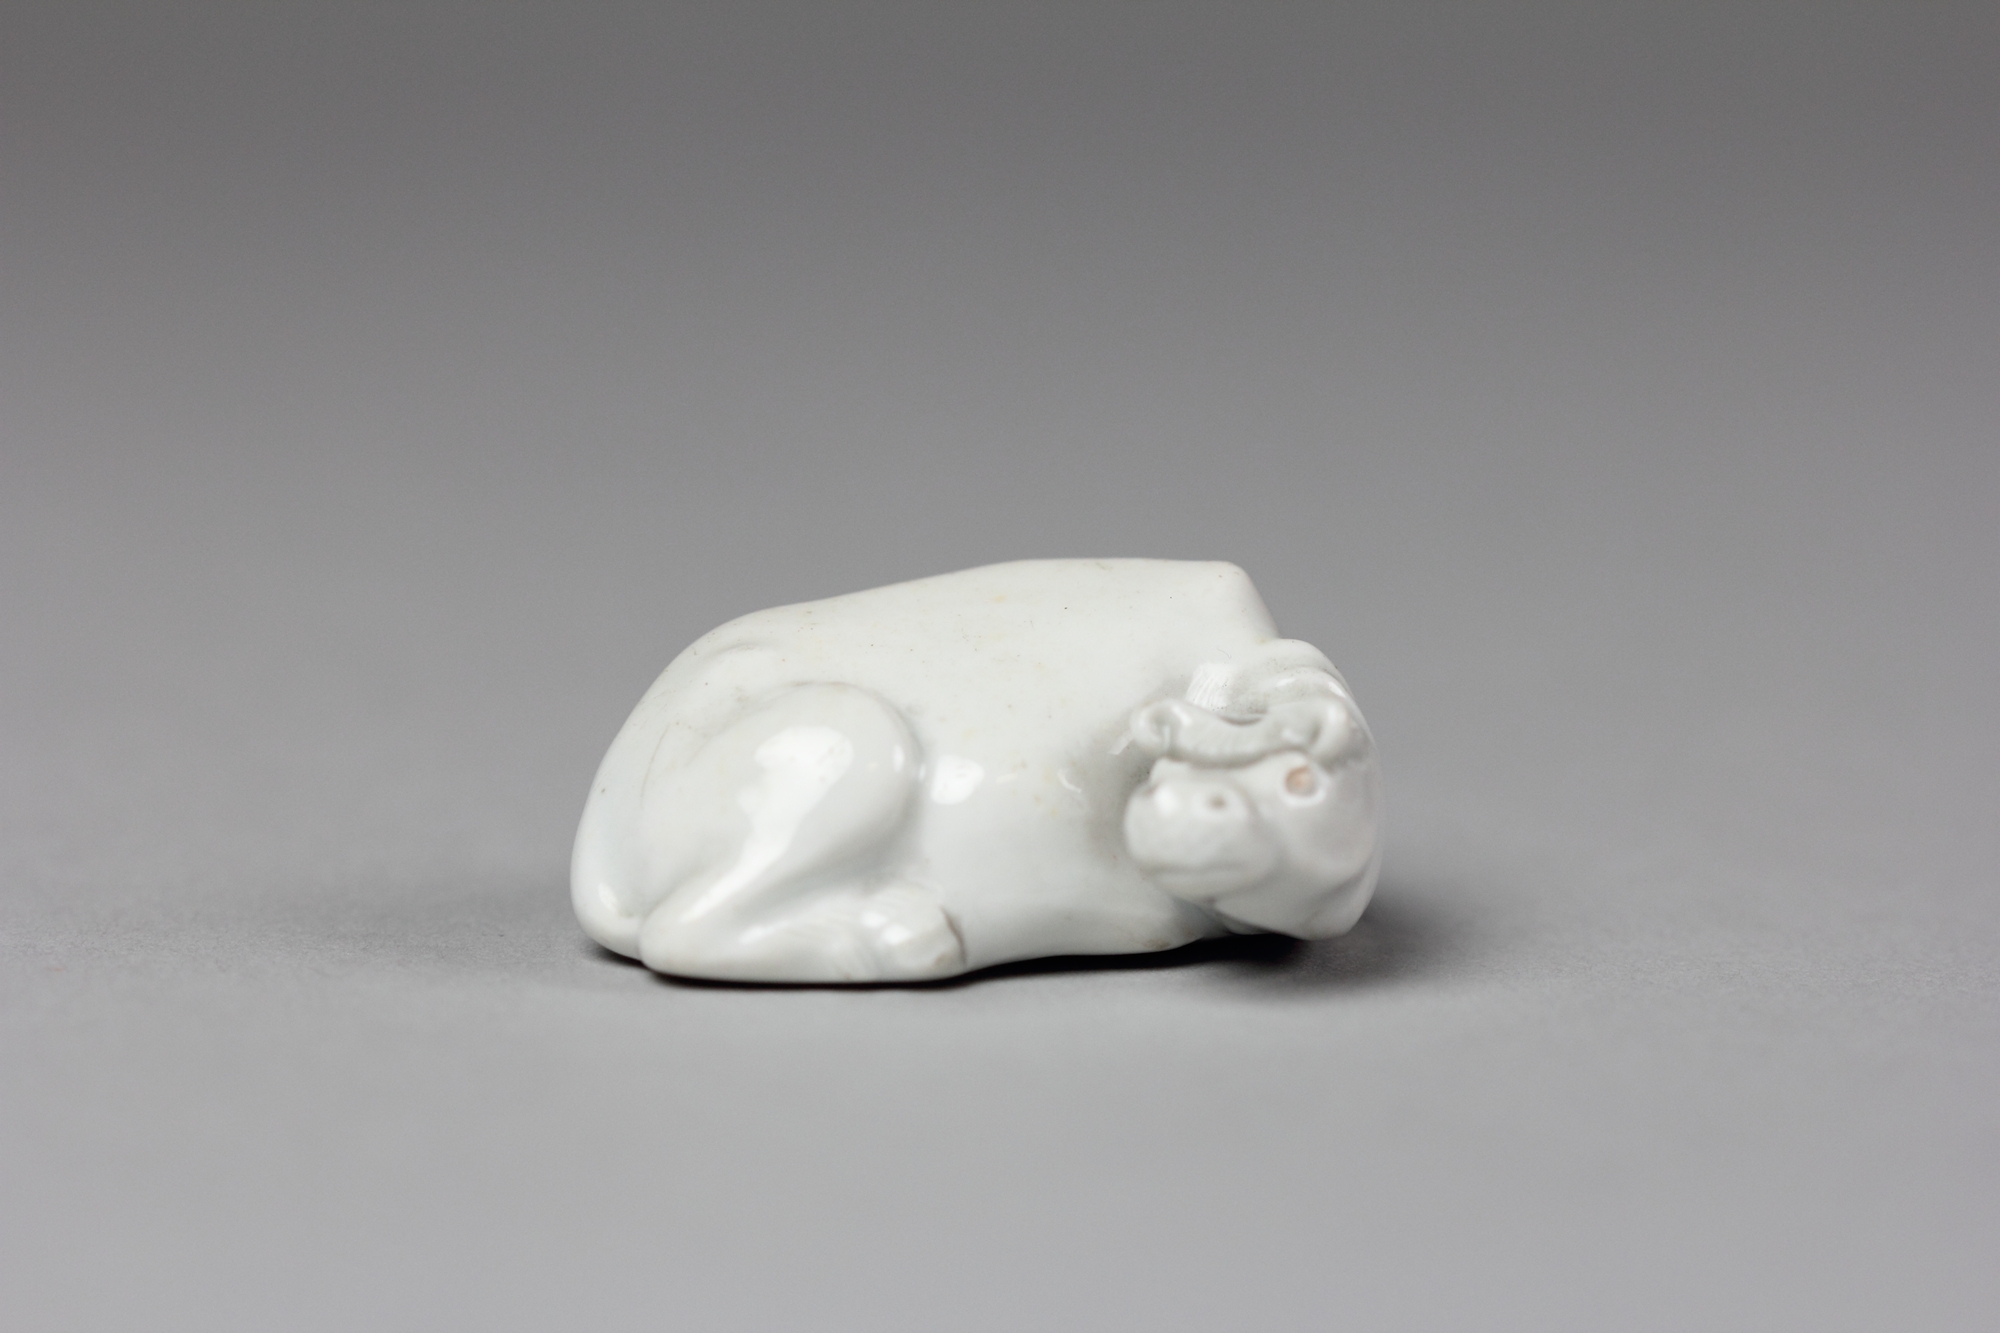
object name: netsuke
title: Netsuke in the Shape of a Bull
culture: japanese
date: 1701-1800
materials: porcelain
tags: bulls